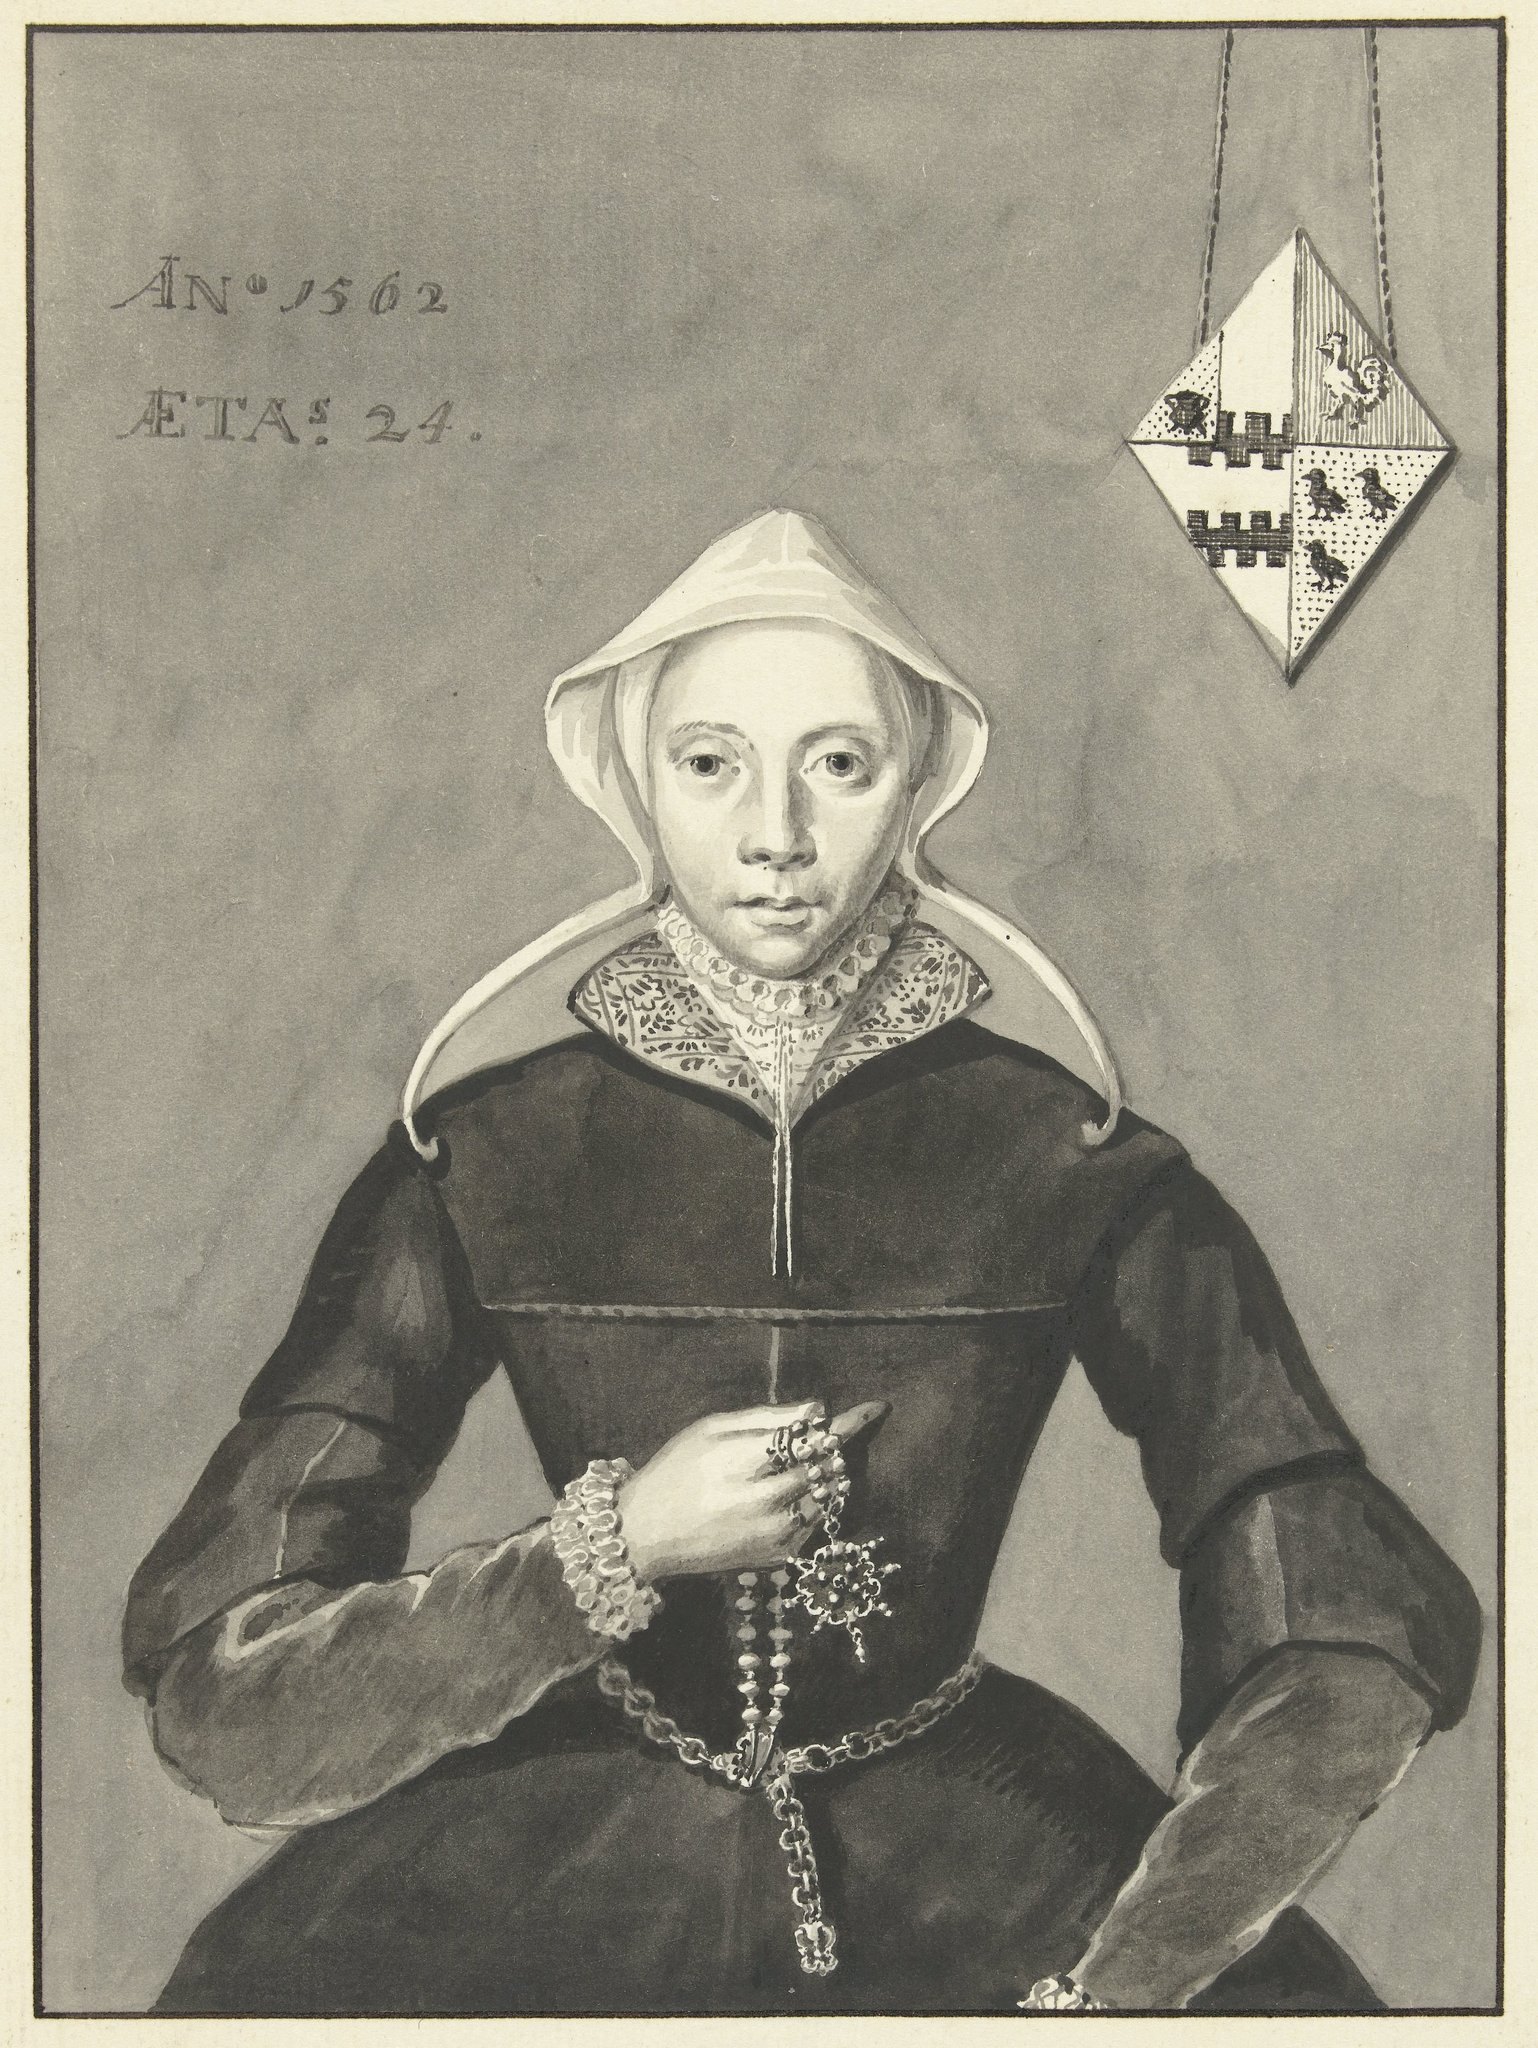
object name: drawing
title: Portret van een vrouw met het wapen Van Slingelandt-Brouwer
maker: aert schouman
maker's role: draughtsman, painter, print maker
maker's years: 1710-1792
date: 1720-1792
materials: ink, paper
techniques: brush, pen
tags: historical persons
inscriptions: inscription: ‘ANo 1562 AETAs 24’